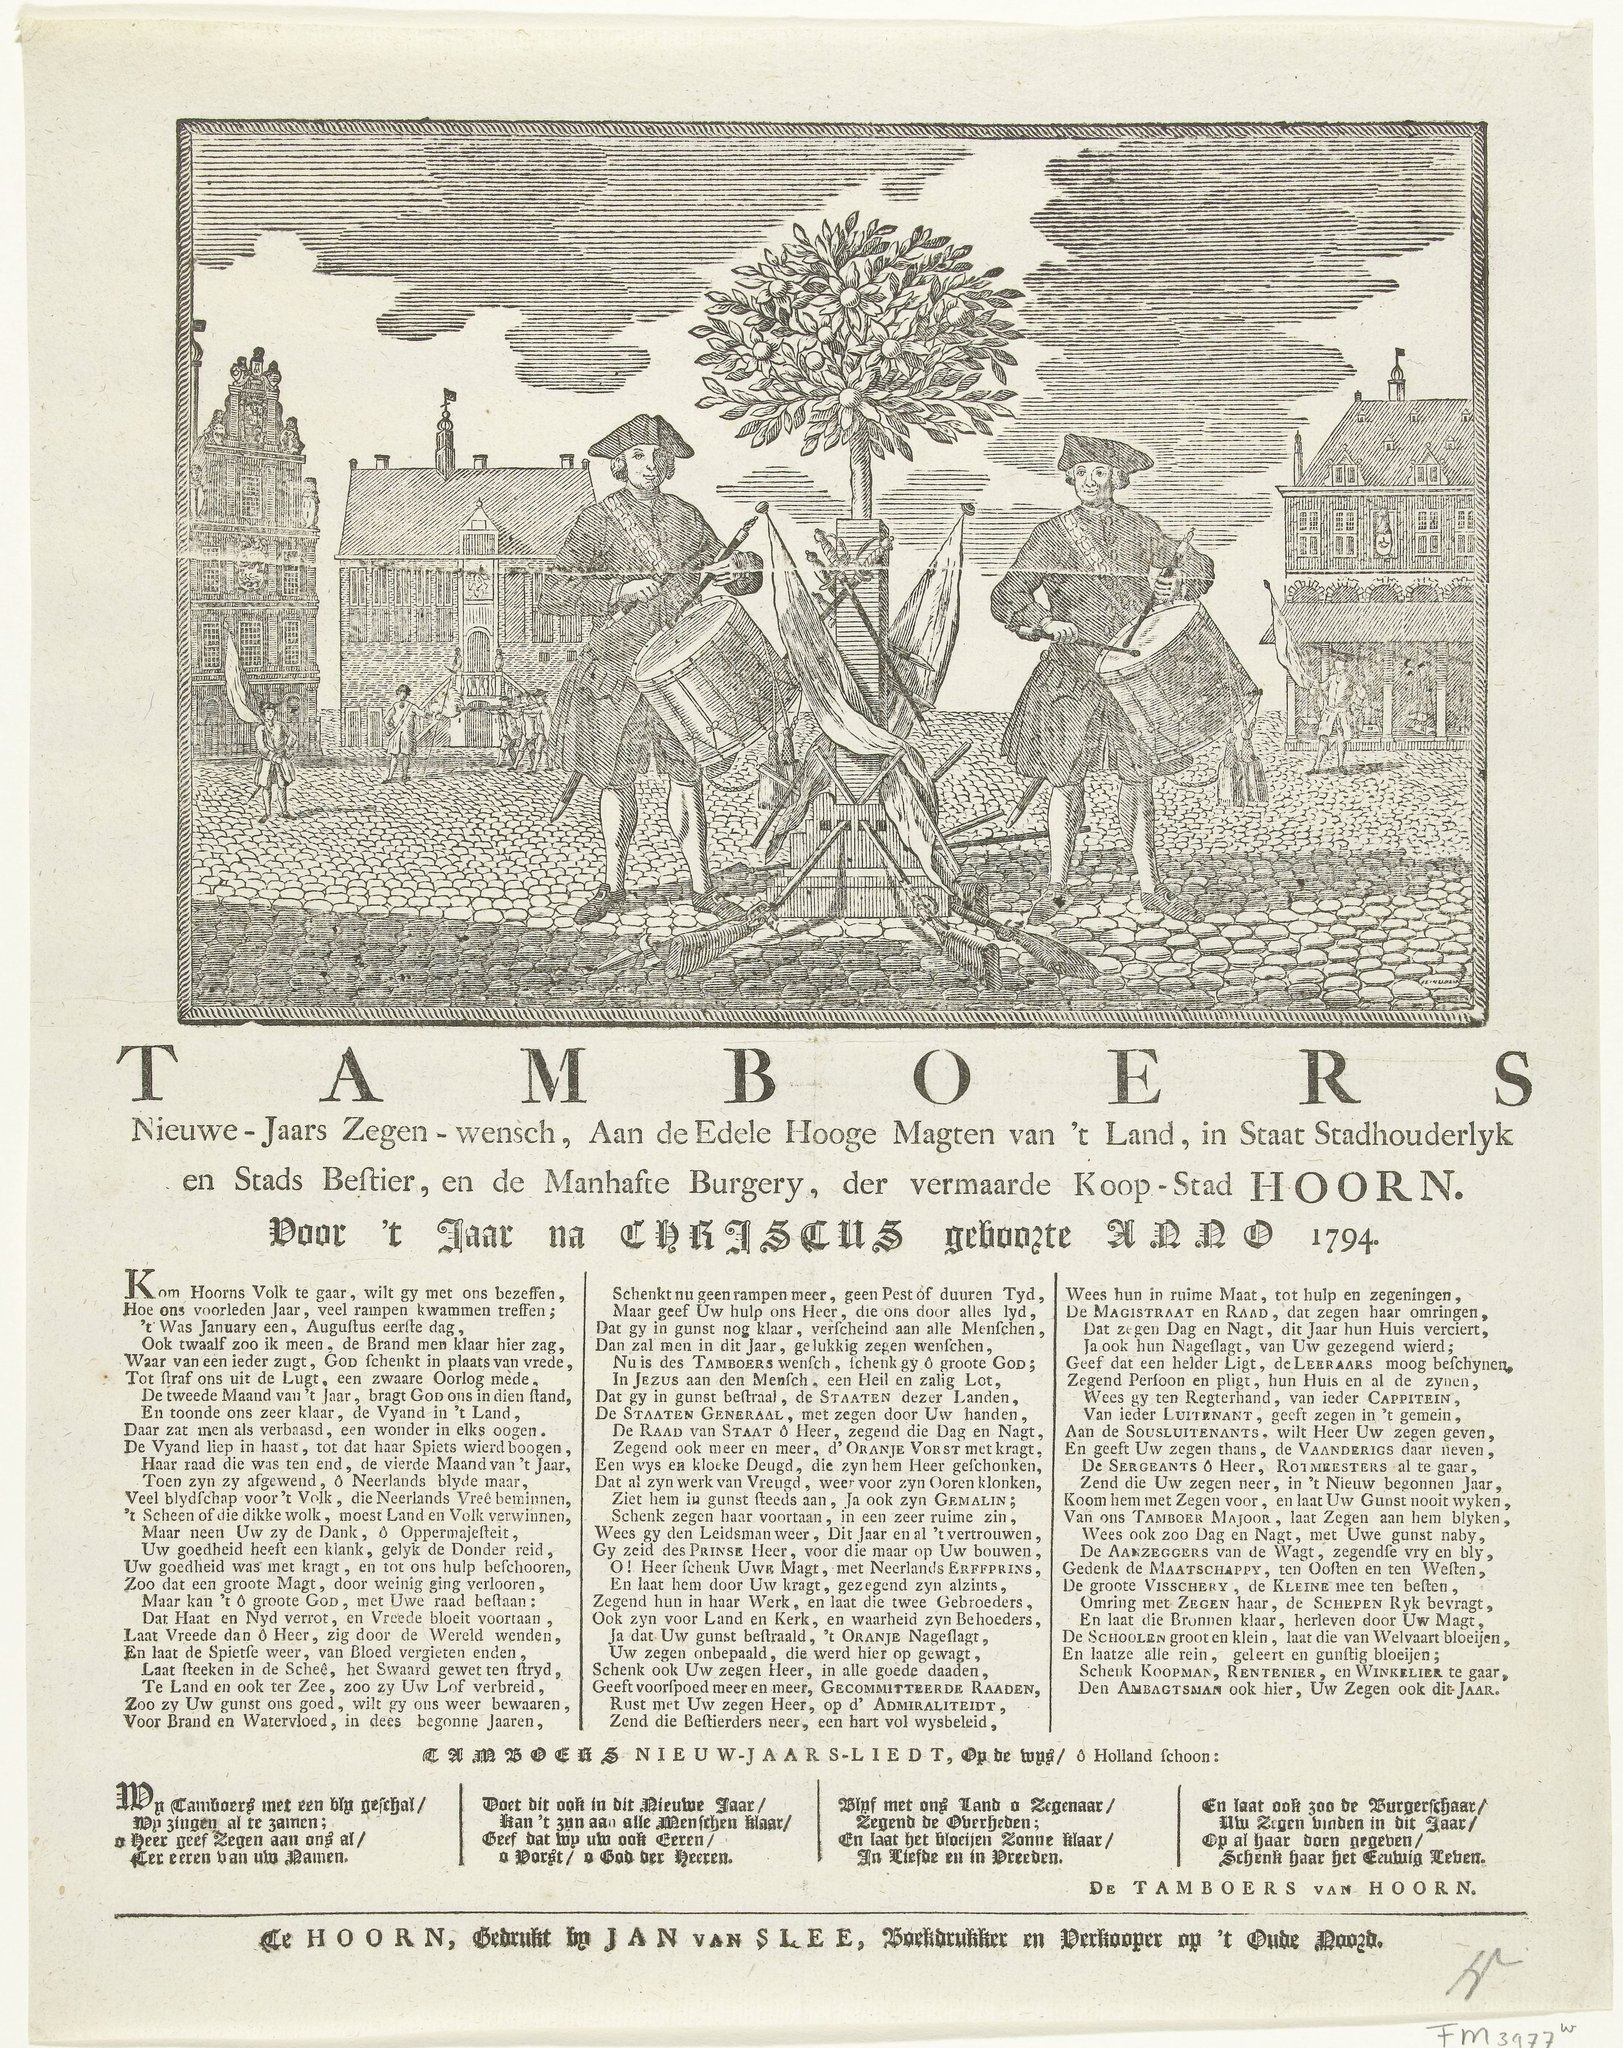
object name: popular print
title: Nieuwjaarsprent van de Hoornse tamboers voor het jaar 1794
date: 1793-1794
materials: paper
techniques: letterpress printing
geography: hoorn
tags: drum (musical instrument) - cc - out of doors, hoorn (north holland)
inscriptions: collector's mark: Lugt 2228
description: Nieuwjaarsprent van de tamboers van de stad Hoorn voor het jaar 1794. Opgedragen aan het stadsbestuur en de inwoners van Hoorn. Twee tamboers met trommels bij een Oranjeboom versierd met wapens en vaandels, op de achtergrond gebouwen aan de Roode Steen te Hoorn, waaronder het oude stadhuis, de Waag en het Statencollege. Op het blad onder de voorstelling een vers in drie kolommen met onderaan een lied in vier kolommen.